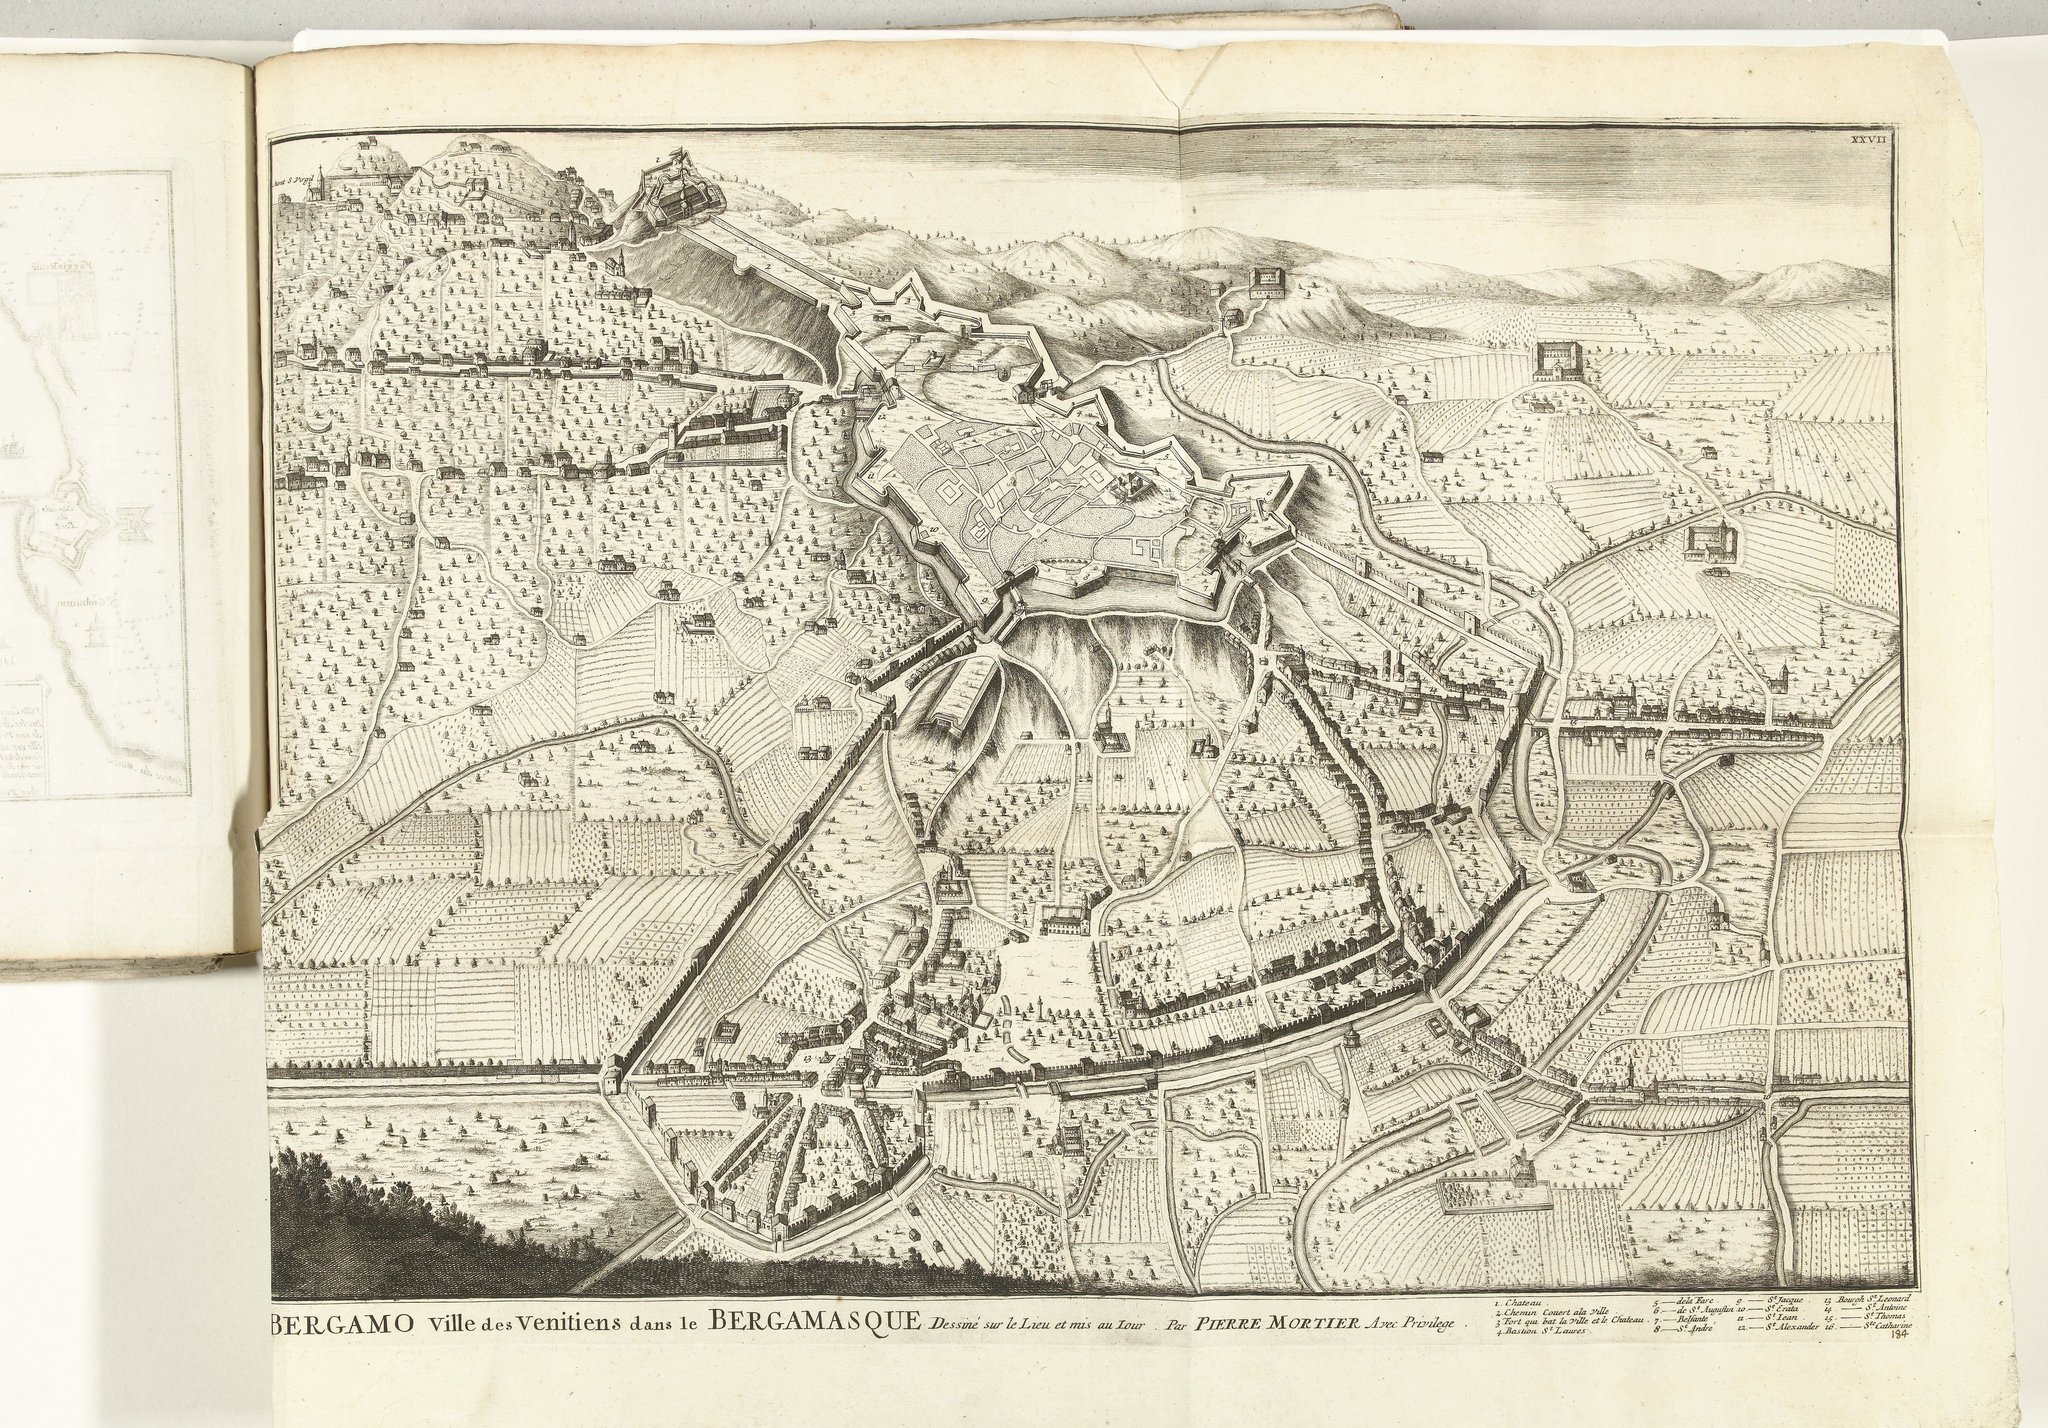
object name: map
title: Plattegrond van Bergamo, ca. 1702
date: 1702-1703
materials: paper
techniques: etching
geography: amsterdam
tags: fortress, maps of cities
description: Grote plattegrond van de Italiaanse stad Bergamo. Gemerkt rechtsboven: XXVII. Plaat nr. 184 in het prentwerk bestaande in totaal uit 276 genummerde platen van vermaarde sterke steden en vestingen in het kader van de Spaanse Successieoorlog. Voor het merendeel zijn deze platen gekopieerd naar de anonieme Franse platen: in Les forces de l'Europe en in: Le theatre de la guerre, dans les Pays-Bas, beide oorspronkelijk uitgegeven door Nicolas de Fer te Parijs (1693-1697) in het kader van de Negenjarige Oorlog. Titel en opschriften in de plaat in het Frans.